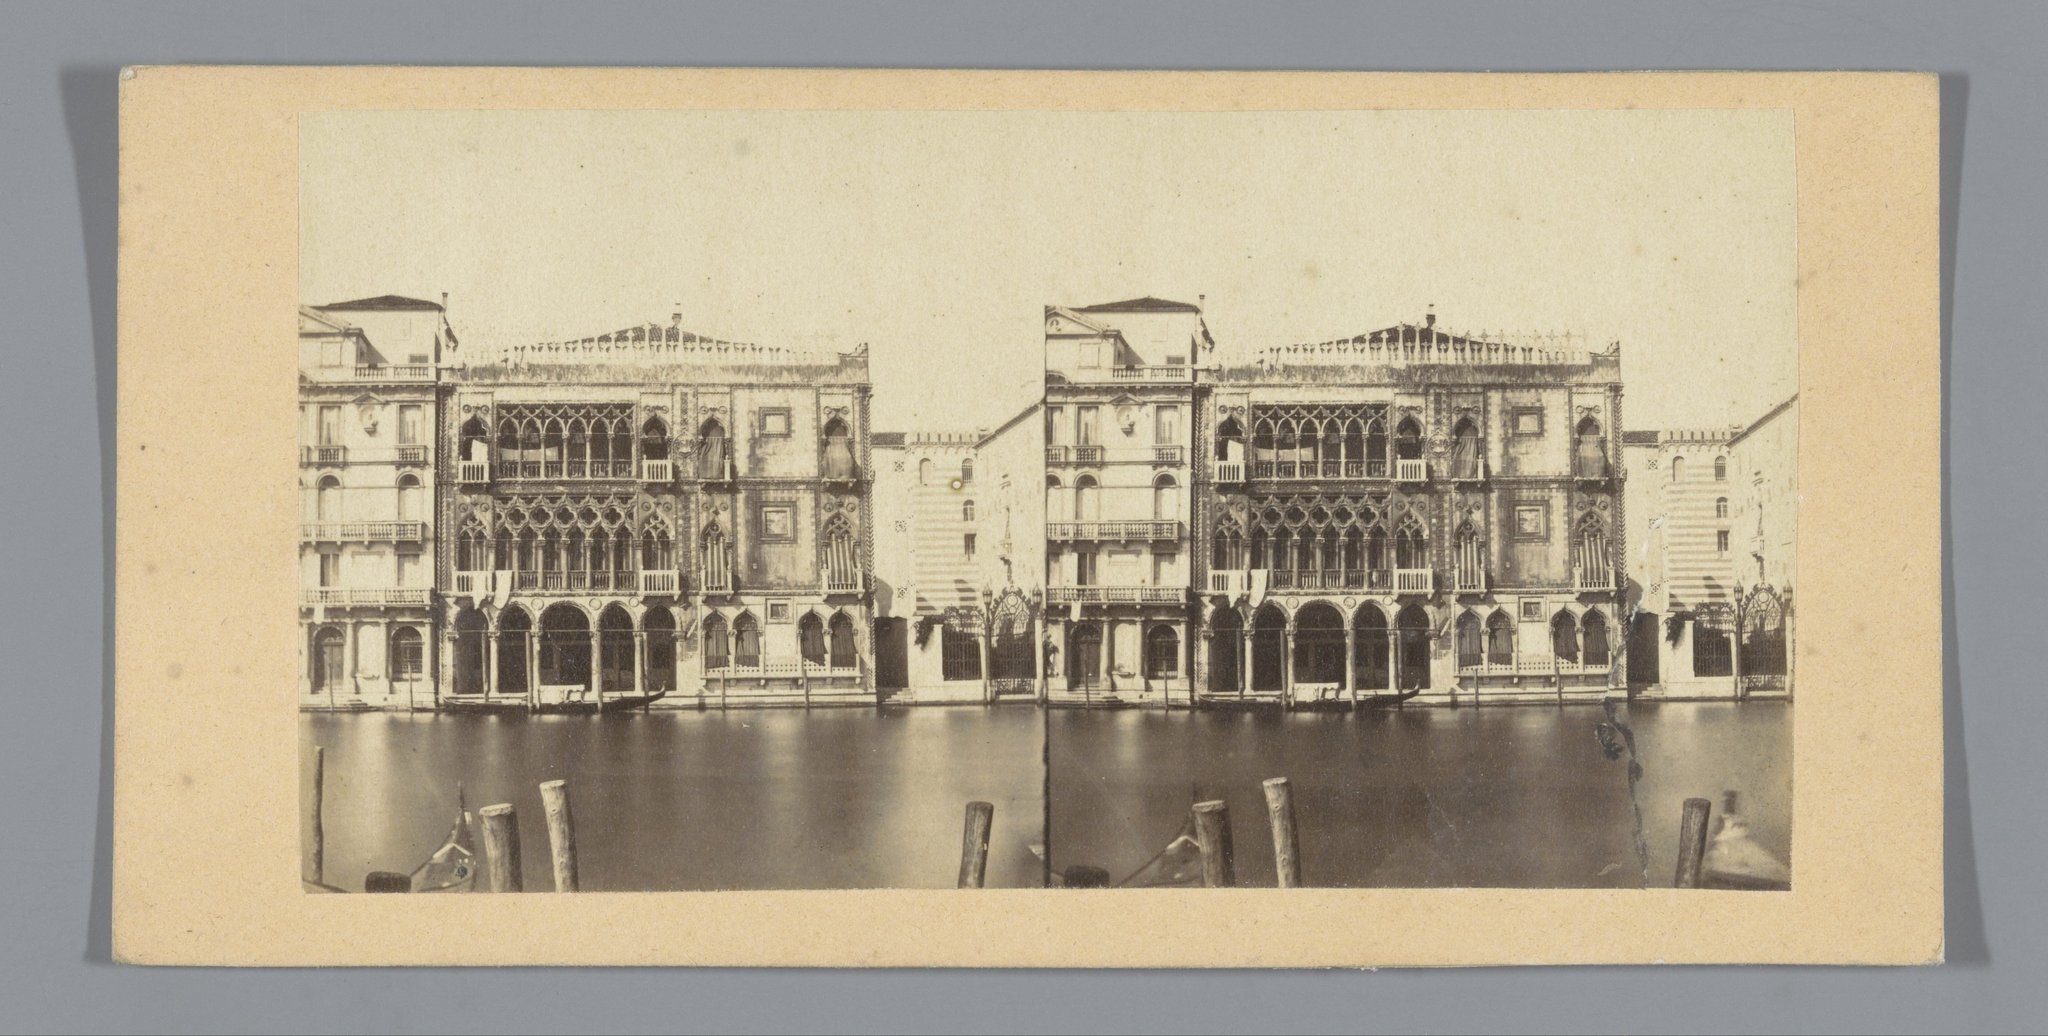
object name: stereograph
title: Gevel van het Ca' d'Oro te Venetië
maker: Anonymous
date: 1850-1880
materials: cardboard, photographic support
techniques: albumen print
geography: venice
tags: canal, façade (of house or building)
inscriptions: inscription: ‘Palazzo Ca' Doro Venezia’